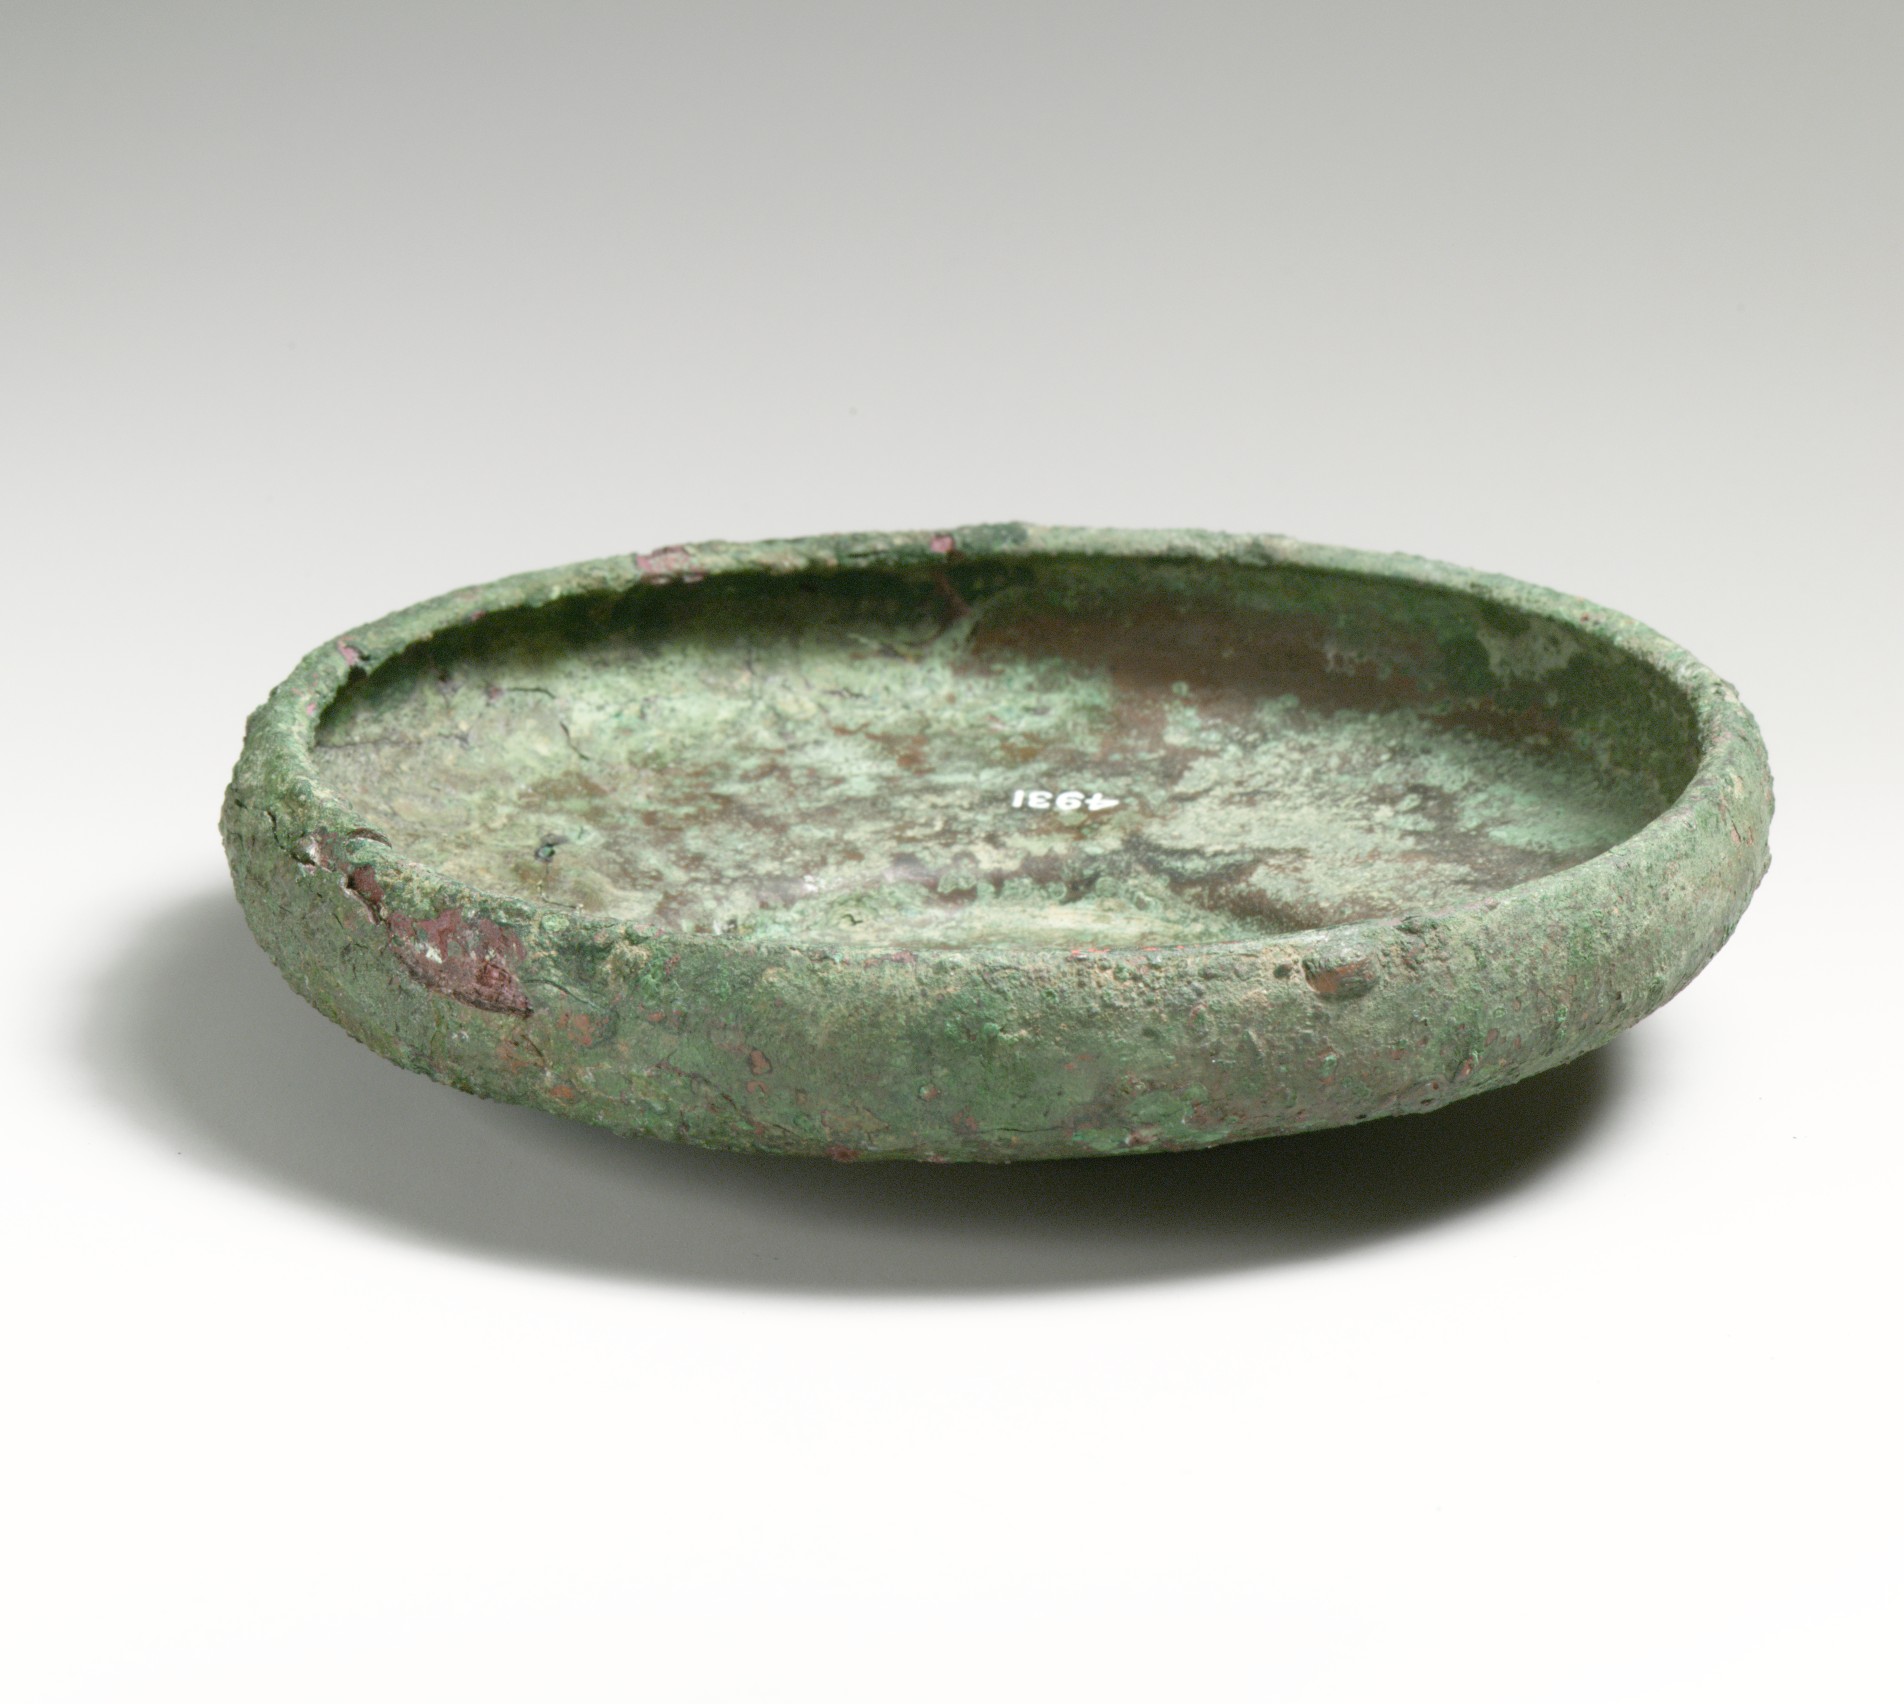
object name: bowl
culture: cypriot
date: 3900 BCE-100 CE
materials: bronze